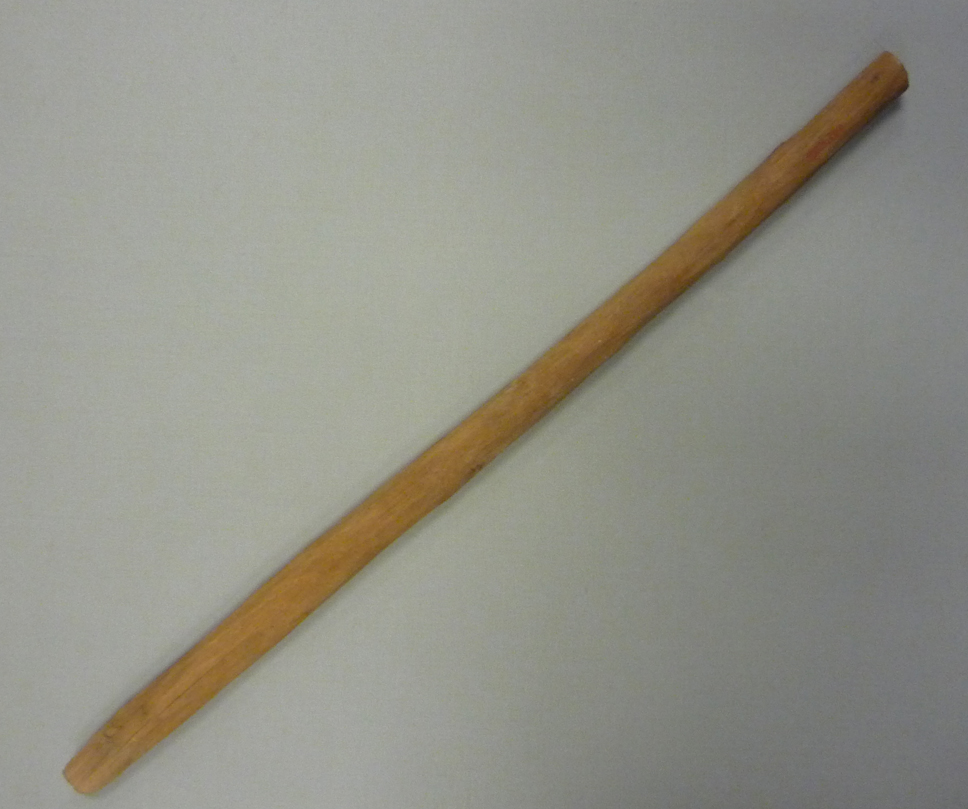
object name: model lever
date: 1550-1295 BCE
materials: wood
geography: egypt